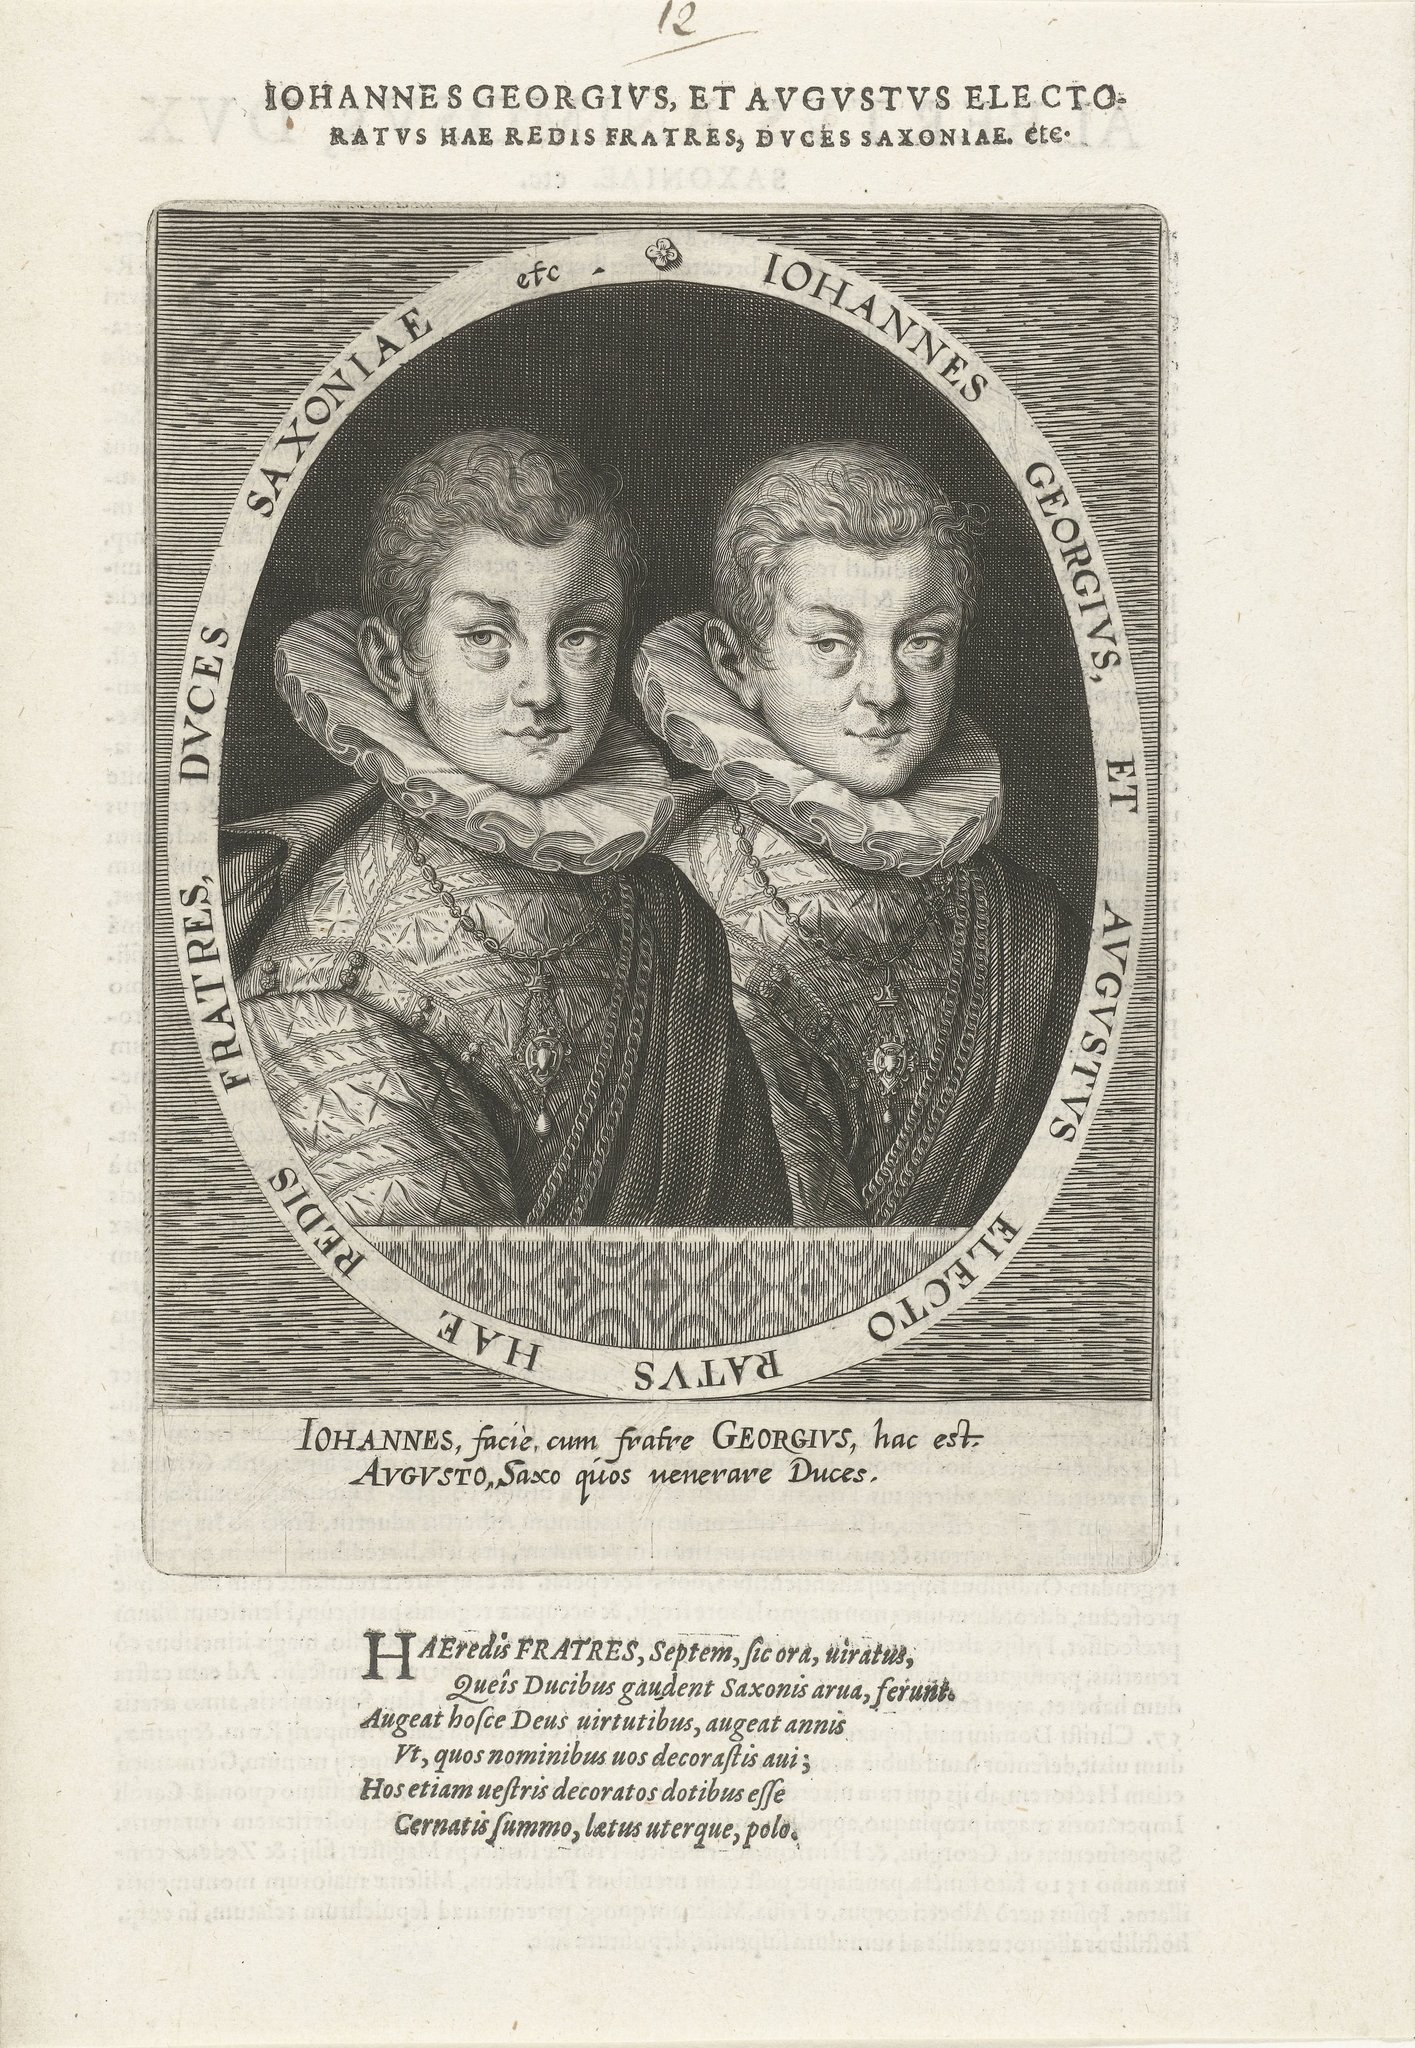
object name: print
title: Dubbelportret van Johann Georg en August van Saksen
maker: dominicus custos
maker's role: print maker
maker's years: 1560-1615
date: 1601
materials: paper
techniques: engraving, letterpress printing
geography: augsburg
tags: johann george van saksen (i)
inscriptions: collector's mark: Lugt 2228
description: Illustratie uit: Saxoniae Ducum. Caesarib. Creand. VIIVirum; et caeterorum A Friderico I. Ad Christianum II. Fratres Et Agnatos, Genuinae effig. Augsburg: D. Custos en M. Manger, 1601, of latere editie.